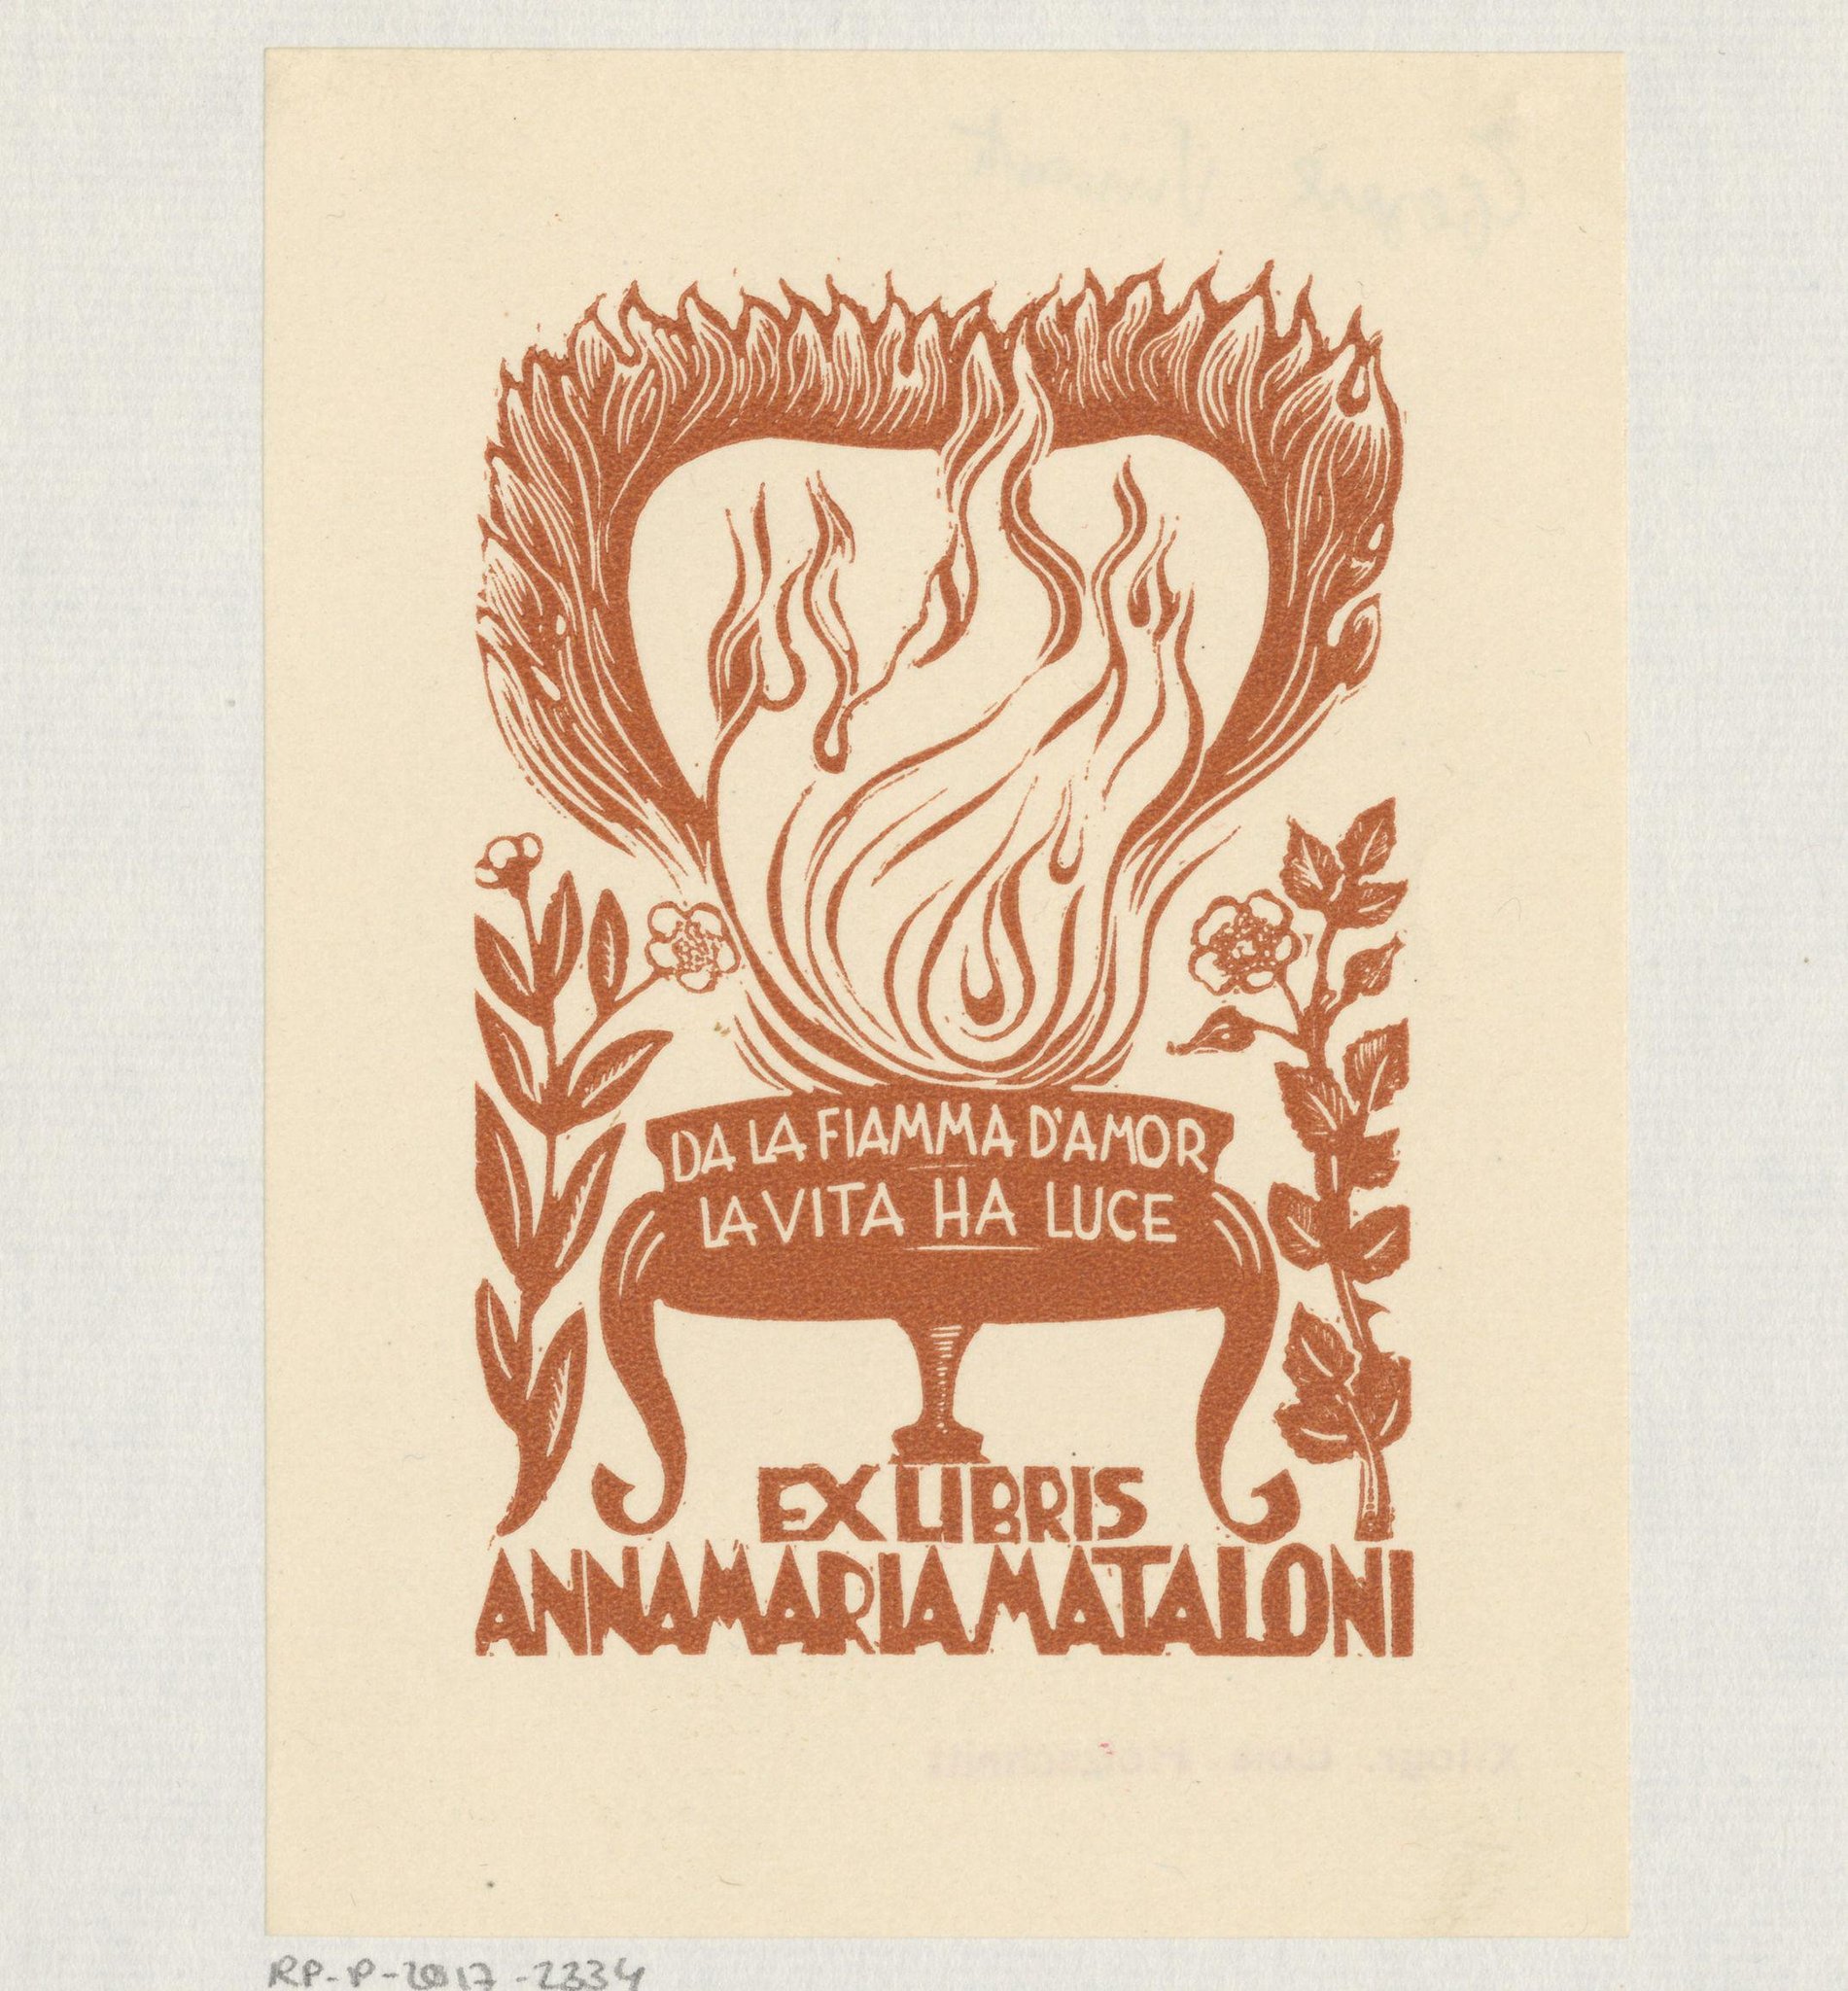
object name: bookplate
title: De la fiamma d'amor la vita ha luce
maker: cesare vincenti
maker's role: print maker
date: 1900-1999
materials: paper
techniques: woodcut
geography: italy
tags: flowers, heart, flame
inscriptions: inscription: ‘Cesare Vincenti’, workshop stamp: ‘Xilogr. Bois Holzschnitt’